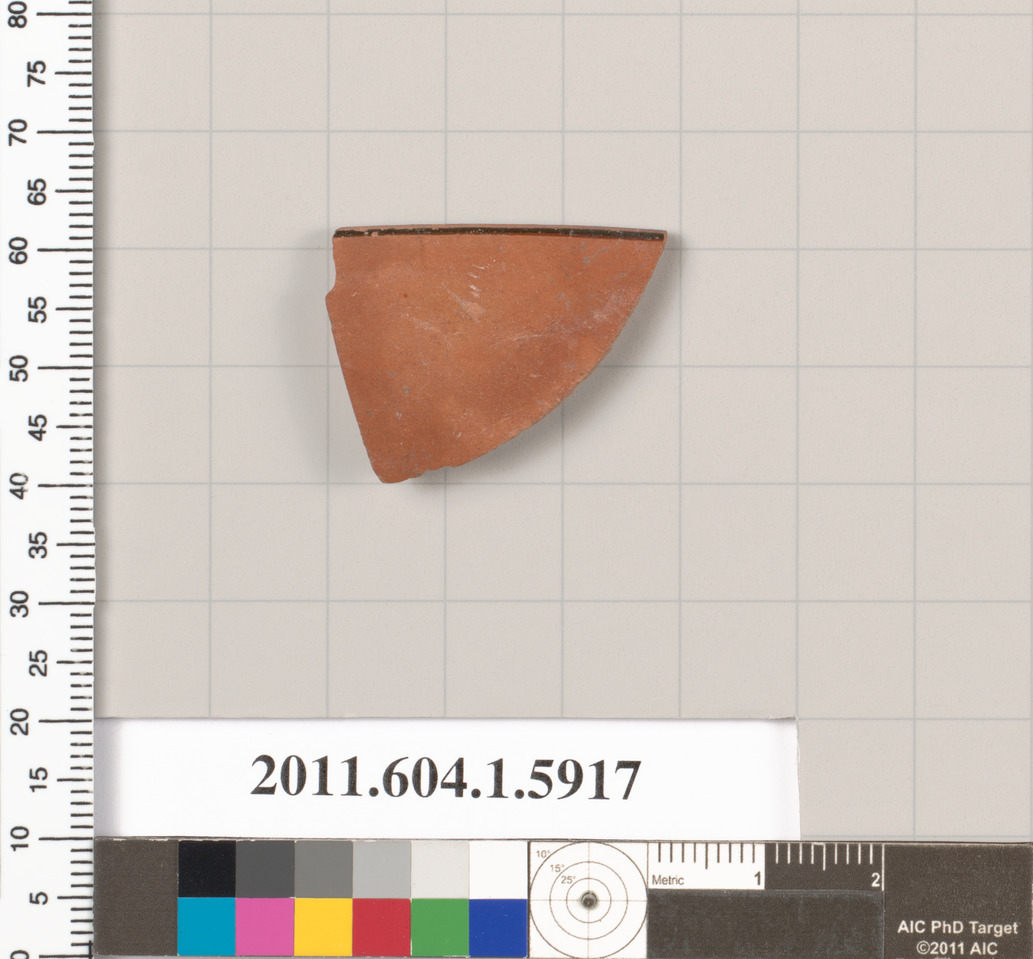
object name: kylix fragment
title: Terracotta rim fragment of a kylix (drinking cup)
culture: greek, attic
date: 520-510 BCE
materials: terracotta